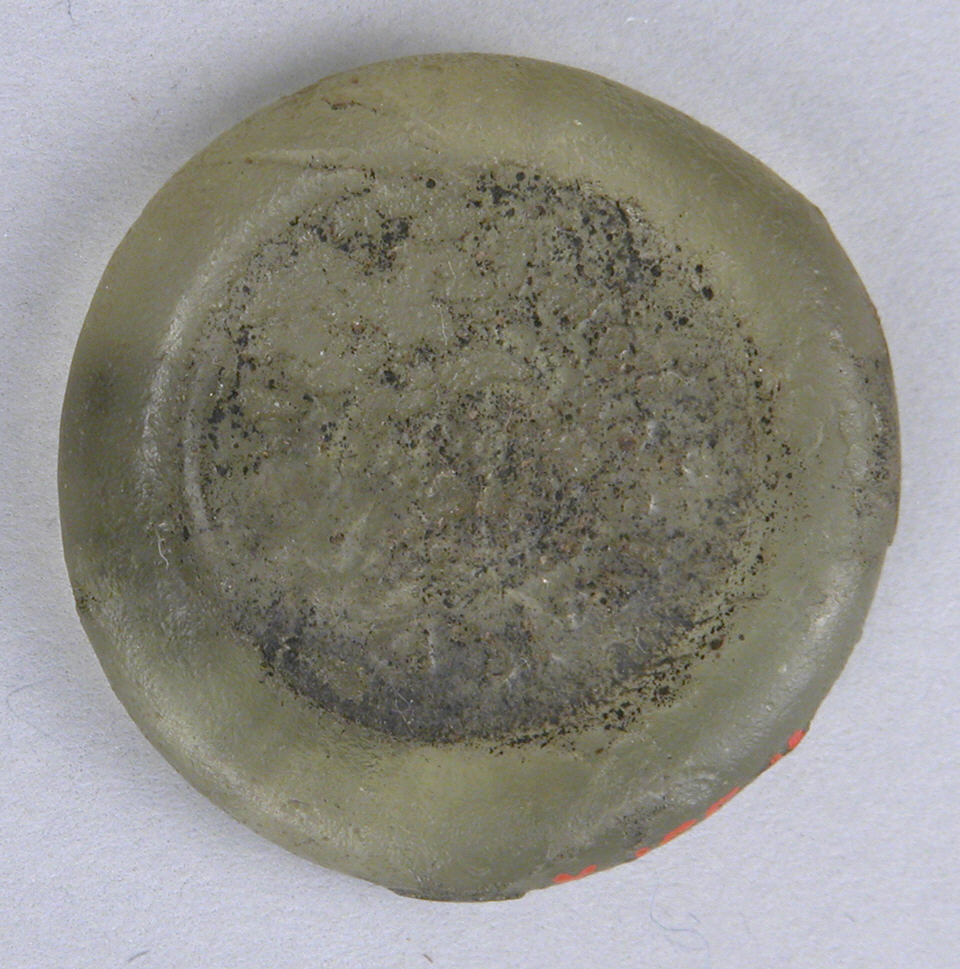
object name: coin weight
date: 1001-1100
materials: glass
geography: egypt